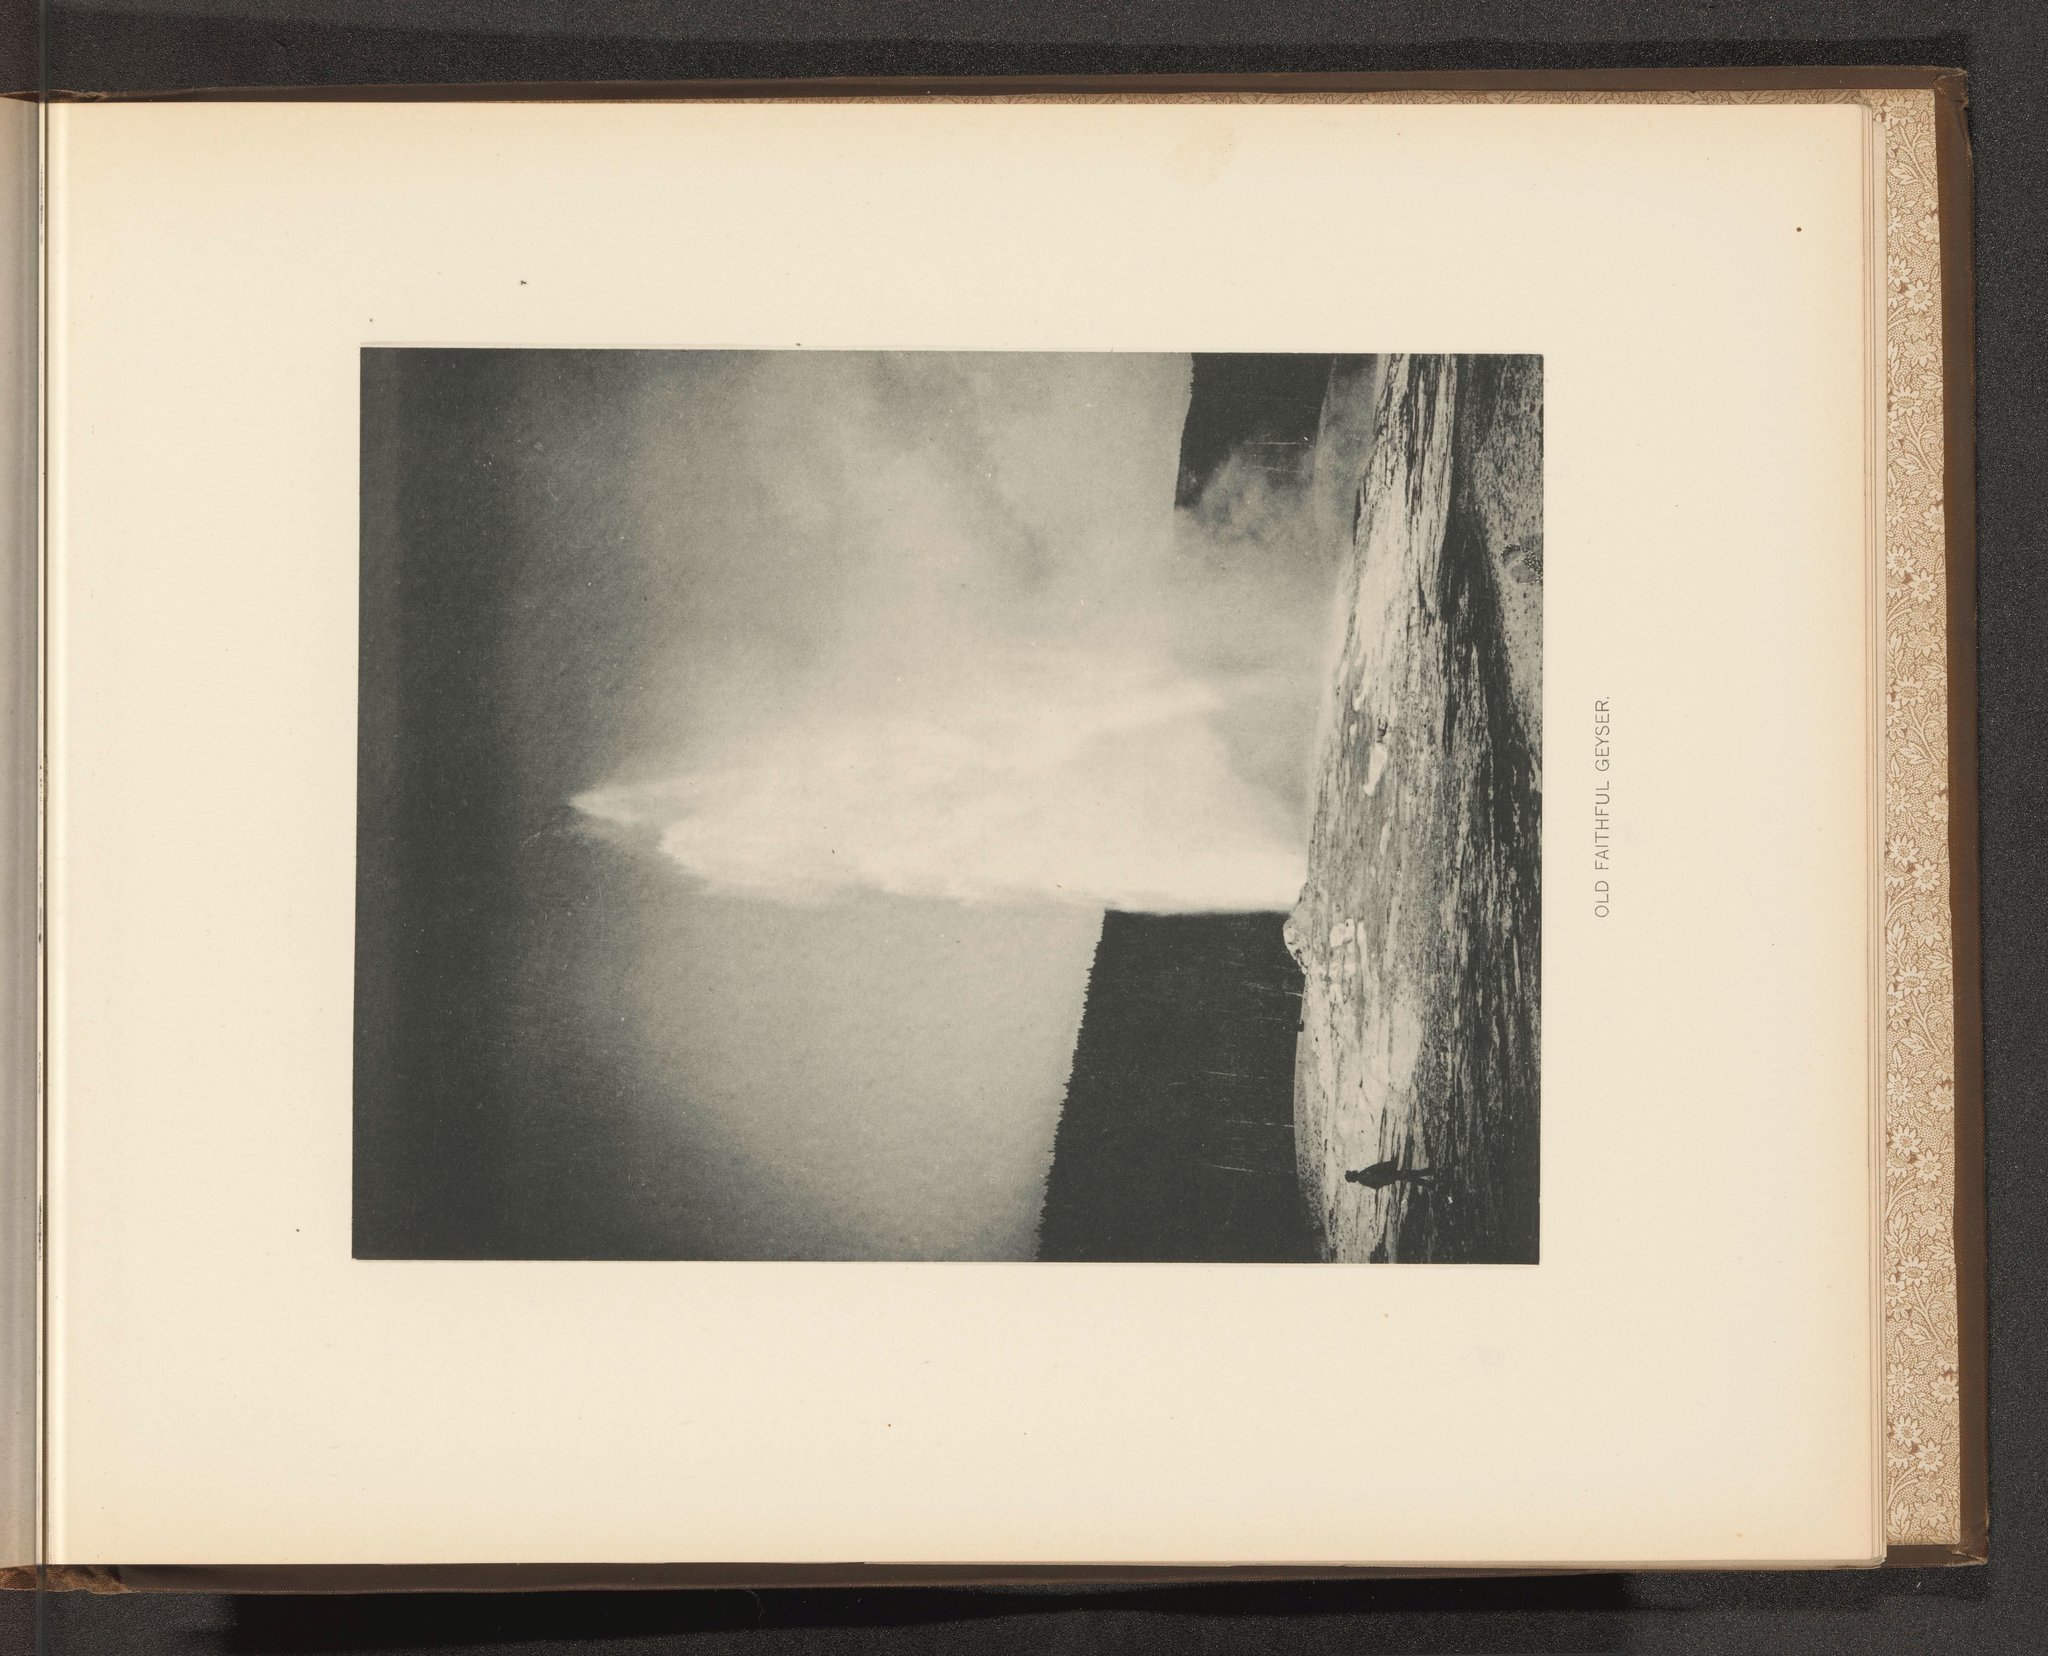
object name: page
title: Old Faithful Geyser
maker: frank jay haynes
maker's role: fotograaf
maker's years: 1853-1921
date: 1886-1891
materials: paper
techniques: photograph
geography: new york city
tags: hot spring, geyser